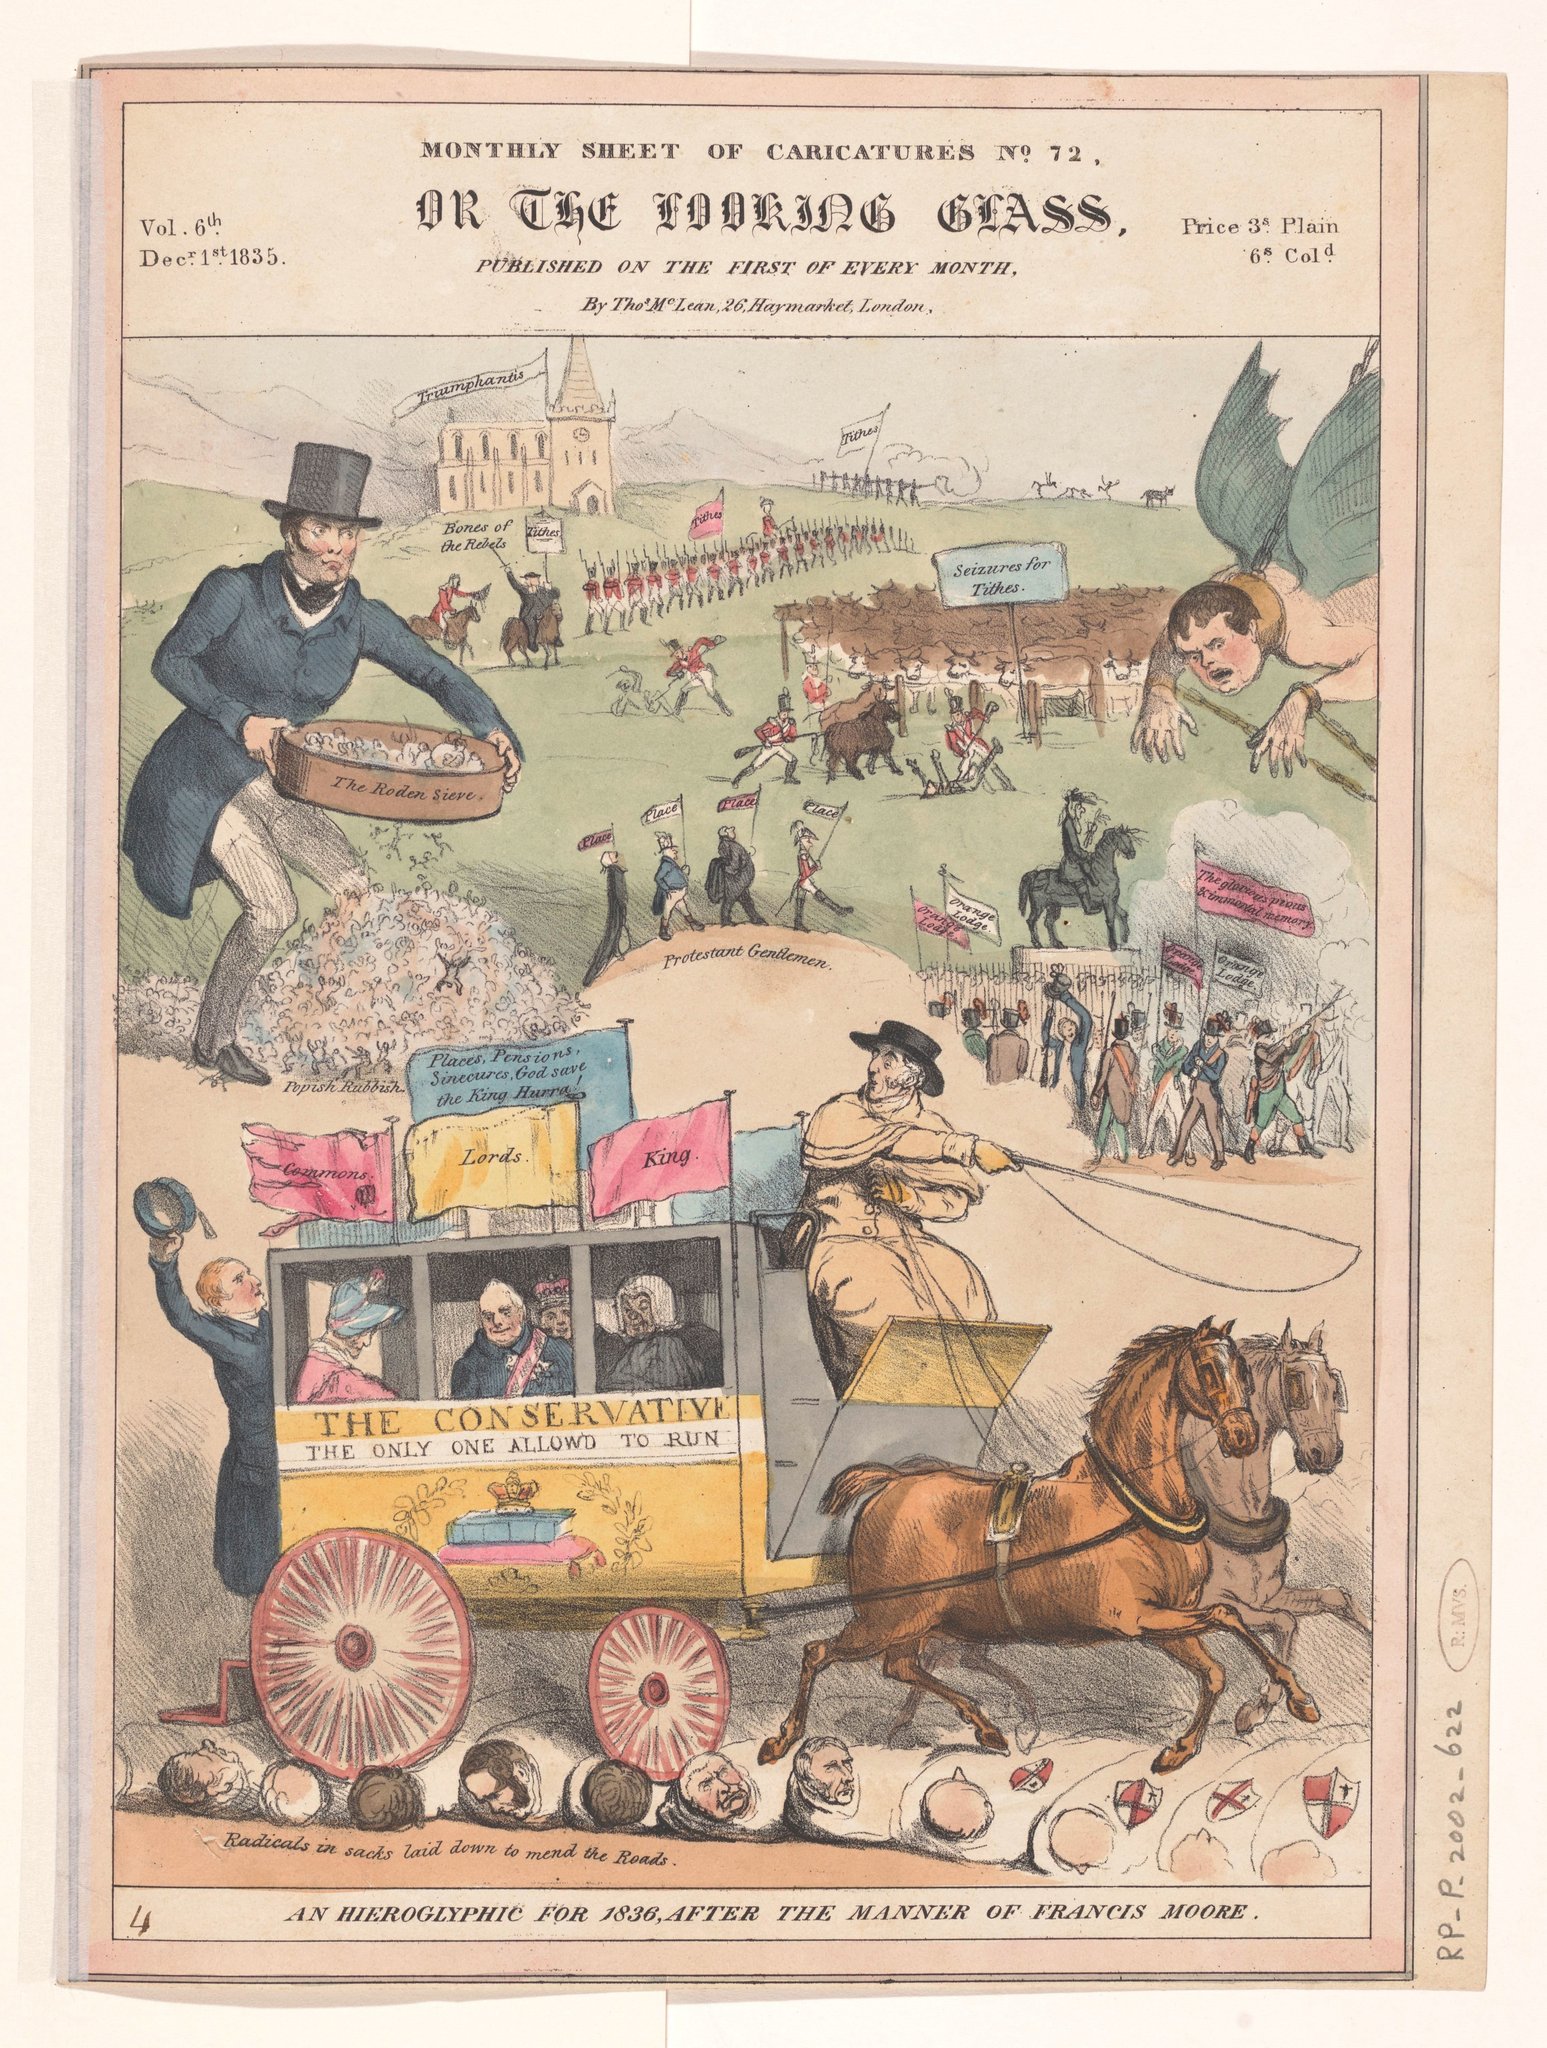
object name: cartoon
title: Monthly sheet of caricatures No. 72, or The Looking Glass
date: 1835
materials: paper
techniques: lithograph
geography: london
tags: bus, coach, political caricatures and satires, england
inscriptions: collector's mark: Lugt 2228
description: De voorplaat van 'Monthly sheet of caricatures No. 72' van 1 December 1835. Blad met allerlei verschillende voorstellingen: onderaan de koets van de conservatieven, linksboven een man met een zeef, etc.